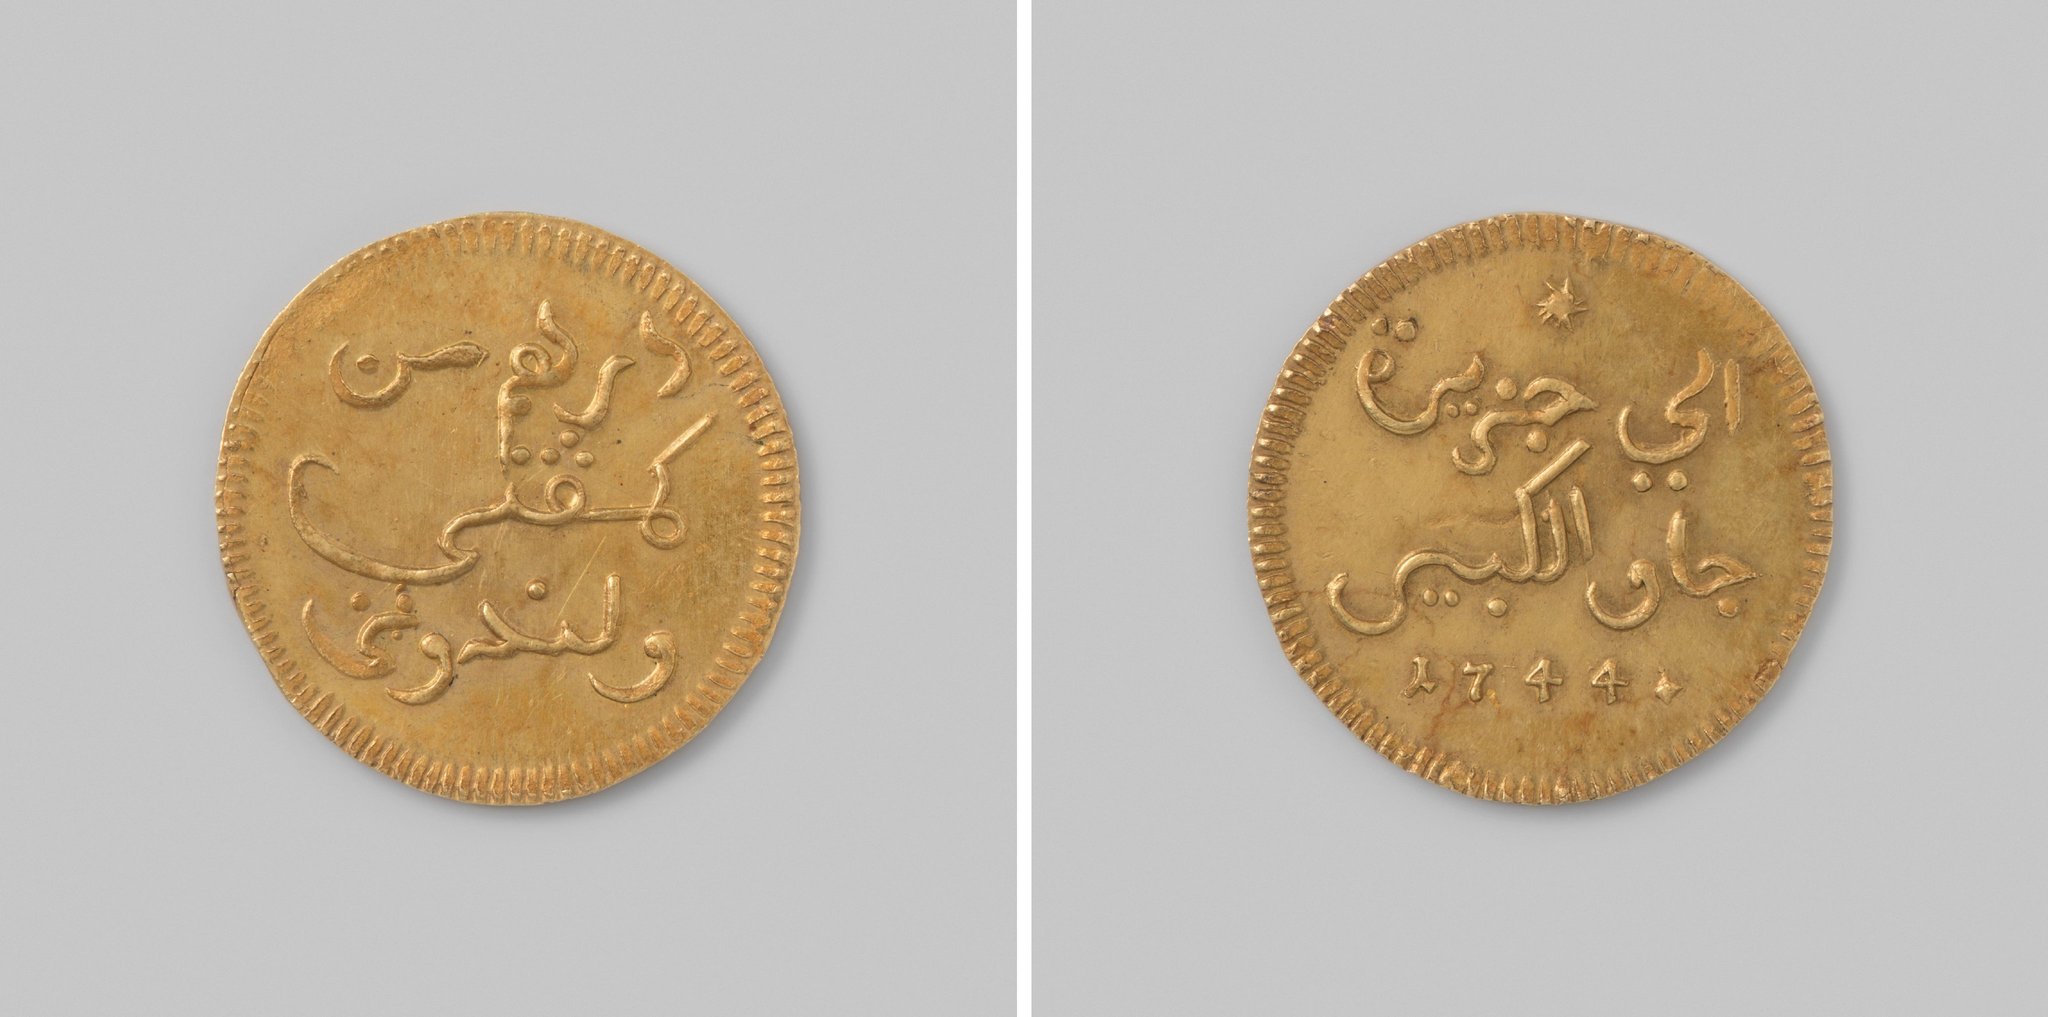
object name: coin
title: Javase dukaat van de VOC, 1744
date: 1744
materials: gold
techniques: striking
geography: batavia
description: Gouden munt. Voorzijde: tweeregelig opschrift in Arabische letters: Ili Jazirat / Jawa al-kabir. Daarboven muntteken: ster en daaronder jaartal. Keerzijde: drieregelig opschrift in Arabische letters: derham min / Kompani / Walandawi. Gladde rand.